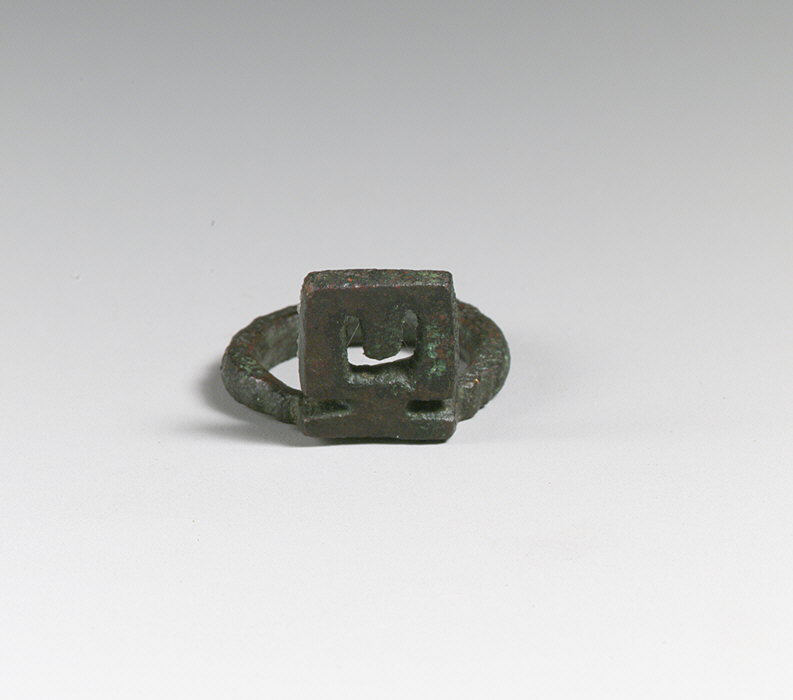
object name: key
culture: roman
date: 670 BCE-330 CE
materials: bronze